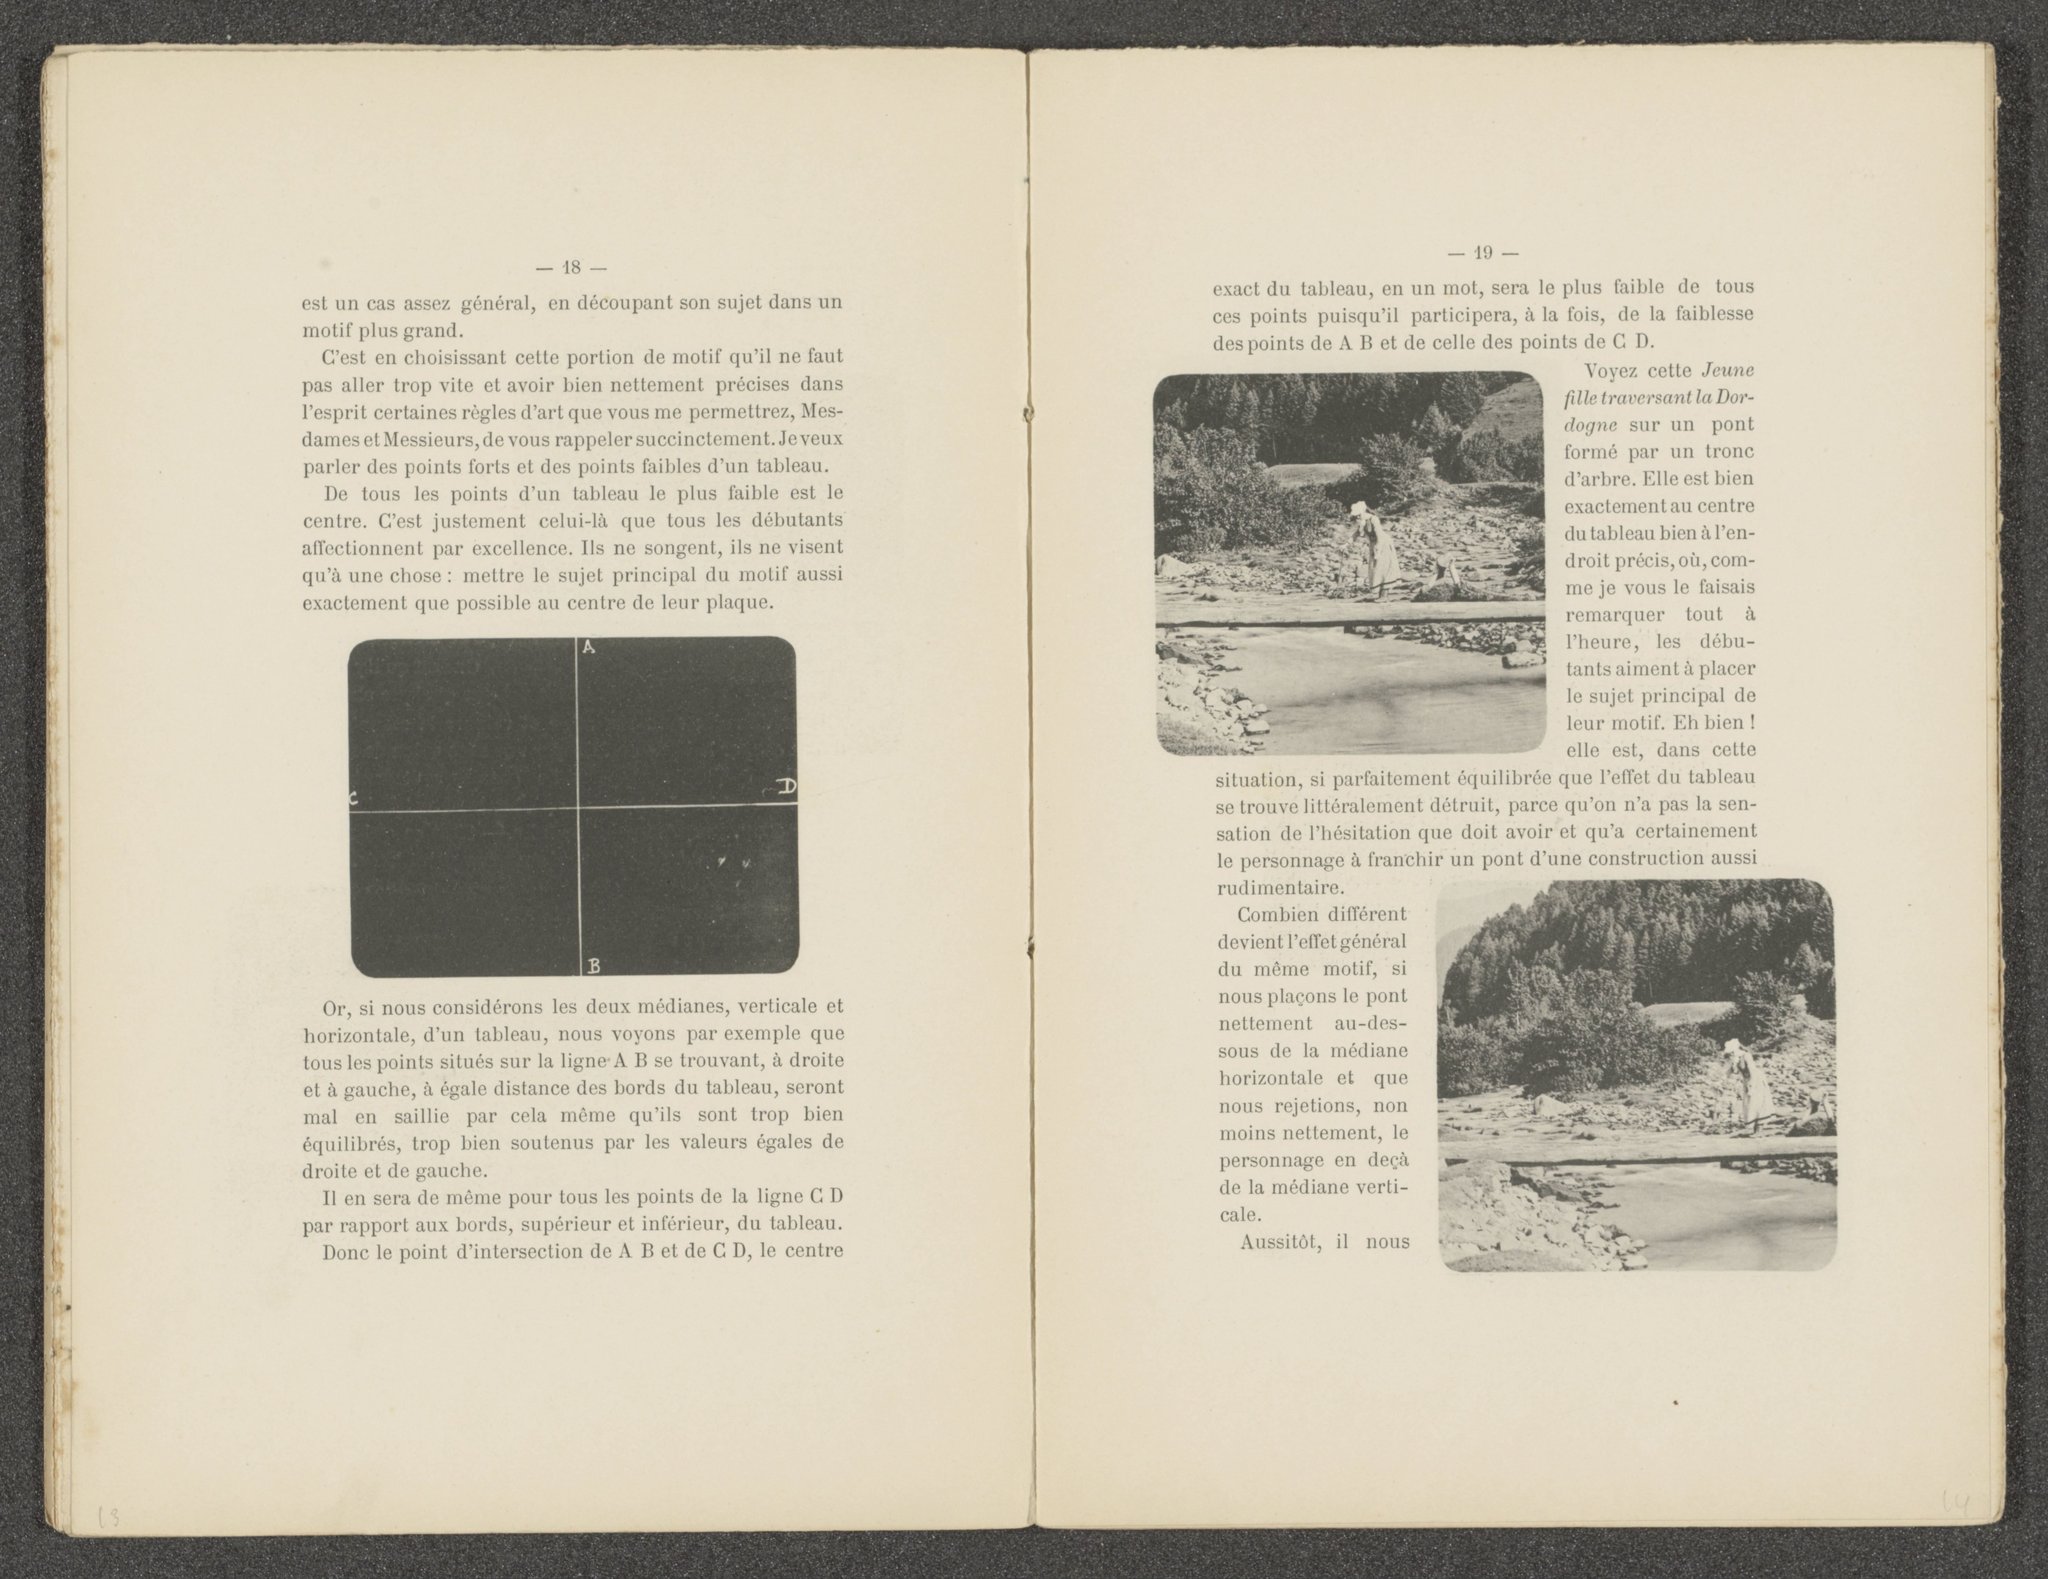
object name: photomechanical print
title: Zwart vlak in vieren gedeeld door twee lijnen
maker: Anonymous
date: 1886-1896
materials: paper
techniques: photograph, printing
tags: intersecting lines